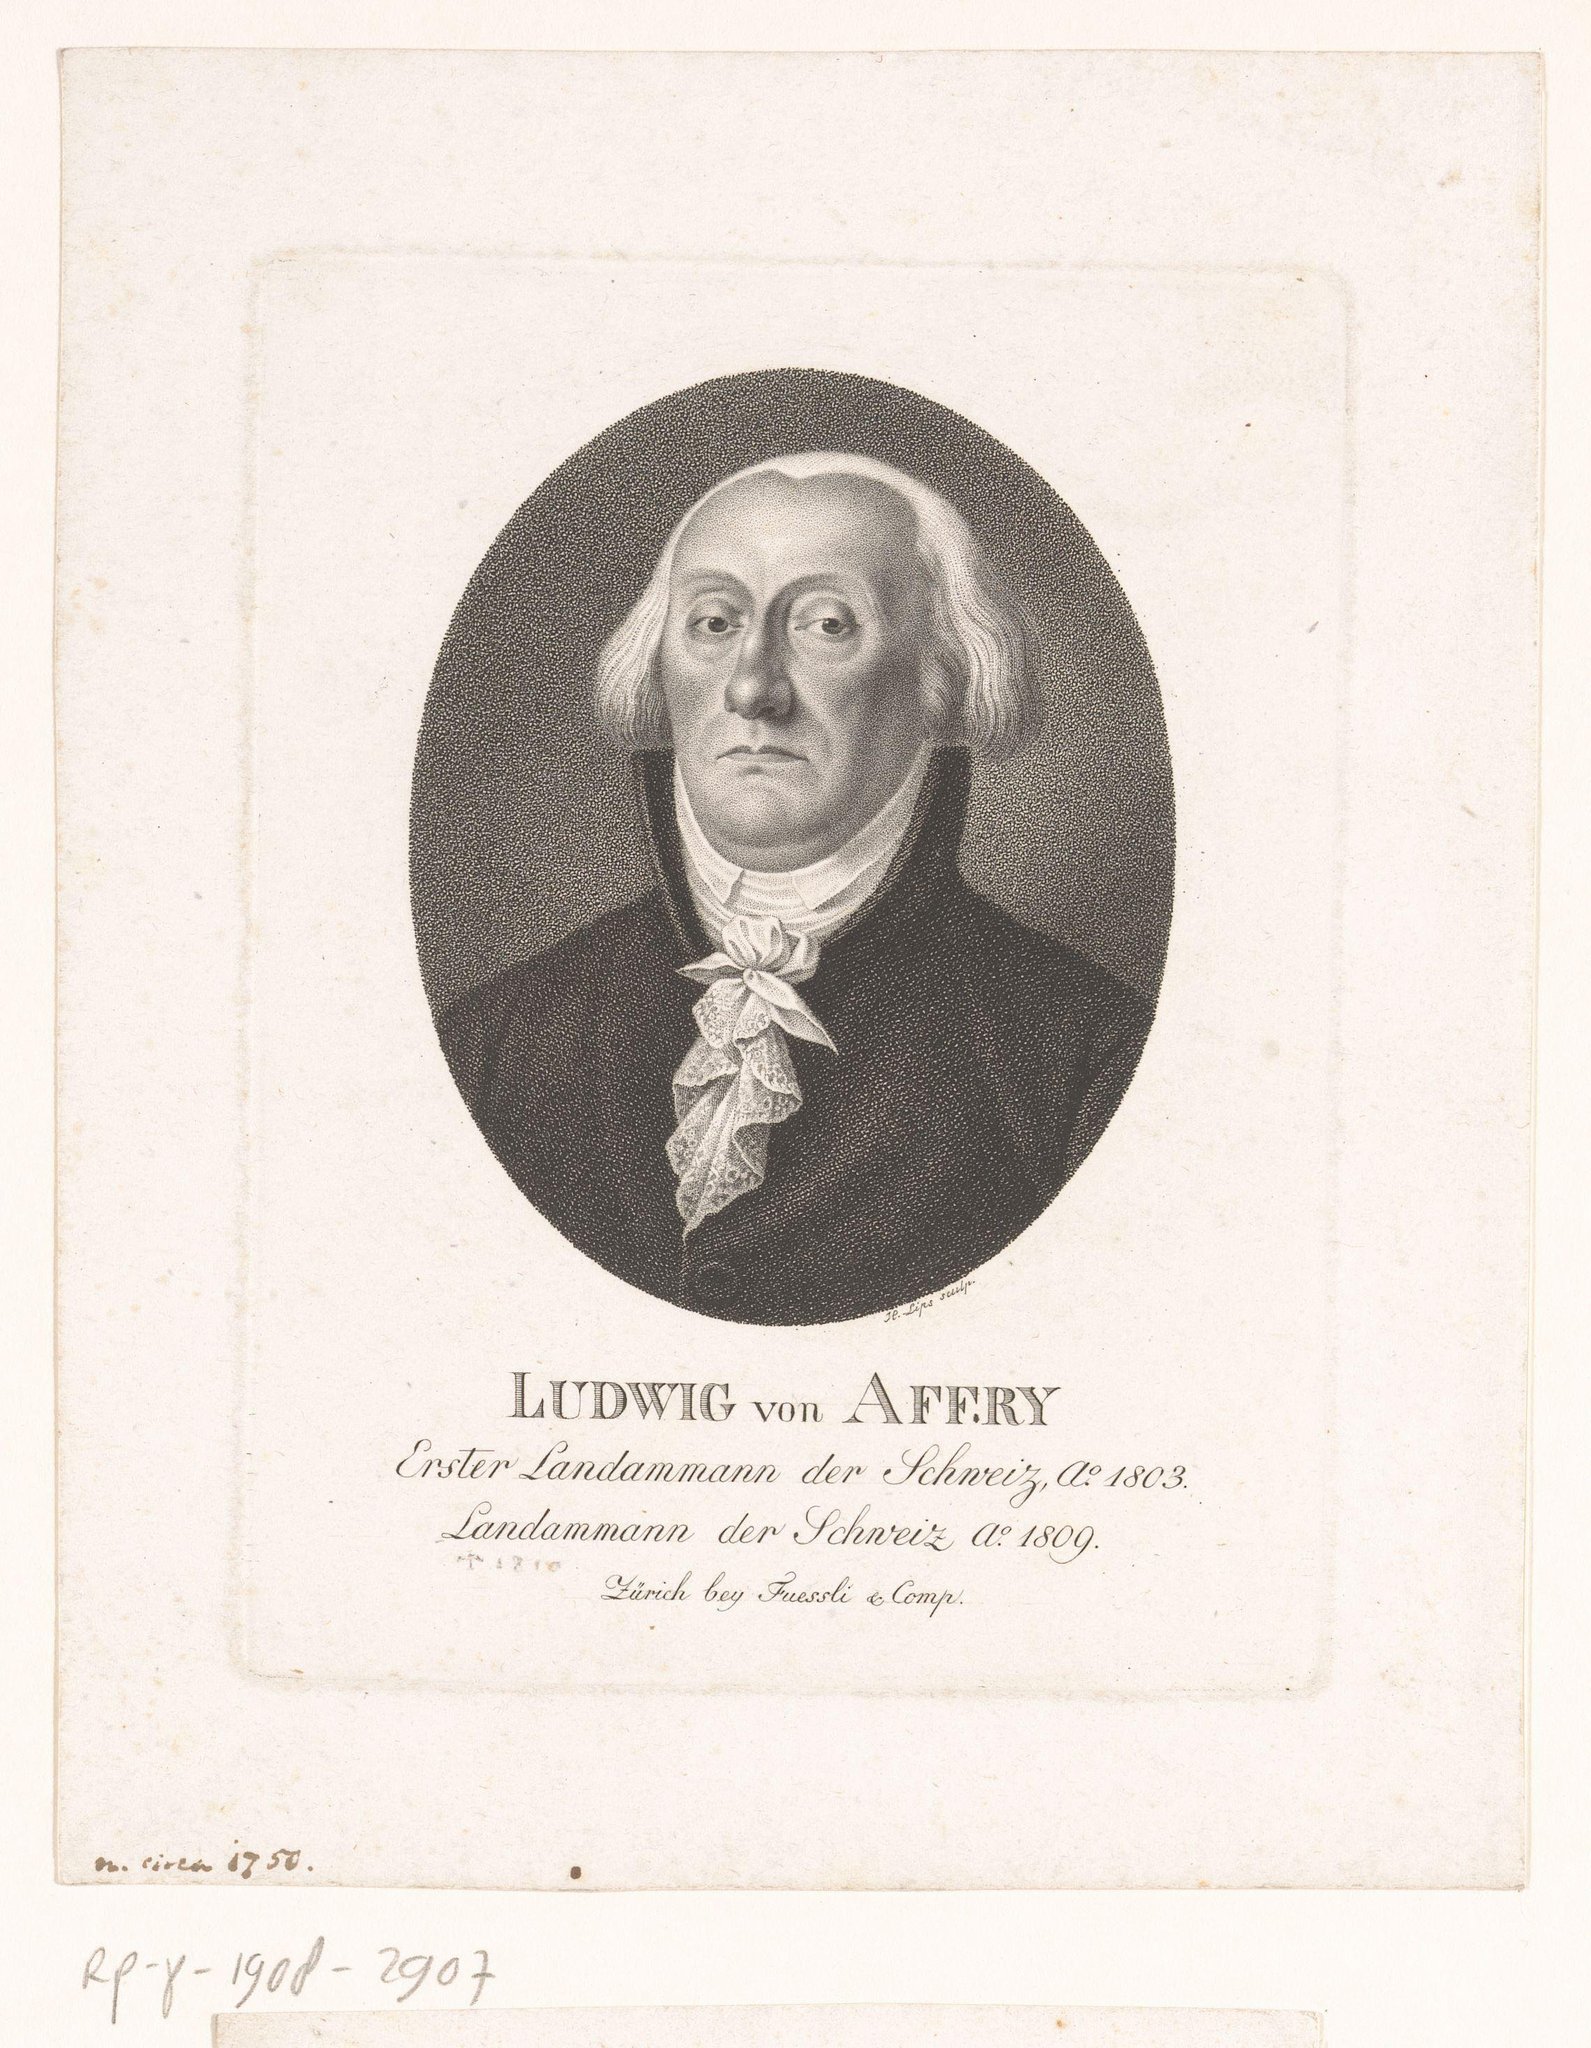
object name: print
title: Portret van Louis d'Affry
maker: johann heinrich lips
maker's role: draughtsman, painter, print maker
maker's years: 1758-1817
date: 1809-1817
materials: paper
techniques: engraving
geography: zurich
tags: politician, historical persons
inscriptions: collector's mark: Lugt 2228